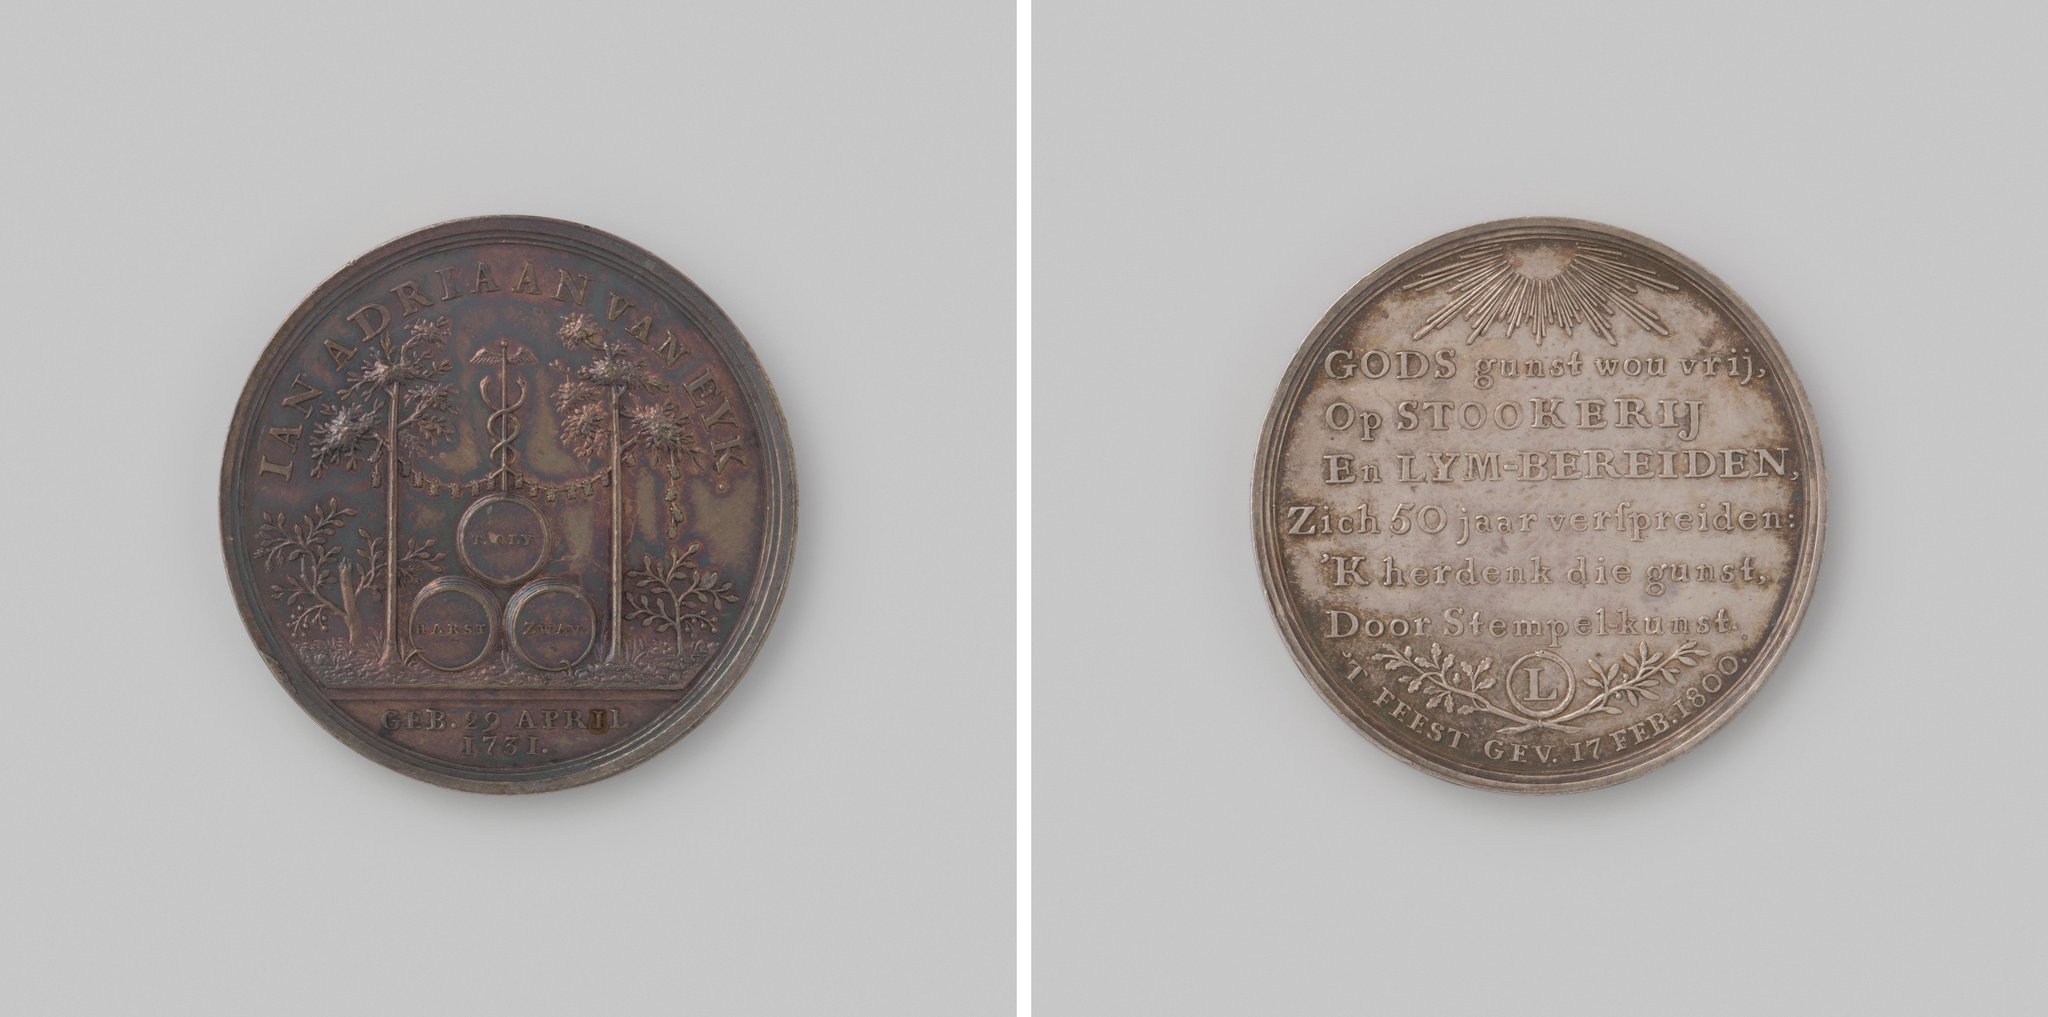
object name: history medal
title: Vijftigjarig bestaan van de fabriek van Jan Adriaan van Eyk te Amsterdam 1800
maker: johan george holtzhey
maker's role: mintmaster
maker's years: 1726-1808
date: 1800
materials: silver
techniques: striking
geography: amsterdam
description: Zilveren penning, op de voorzijde drie vaten, met terpetijnolie, hars en zwavel, waarop een mercuriusstaf, te midden van groeiend loof, met omschrift en afsnedetekst, op de keerzijde zes regels tekst onder een stralende zon, onderaan een slangenrond met L op gekruiste twijgen, met afsnedetekst.